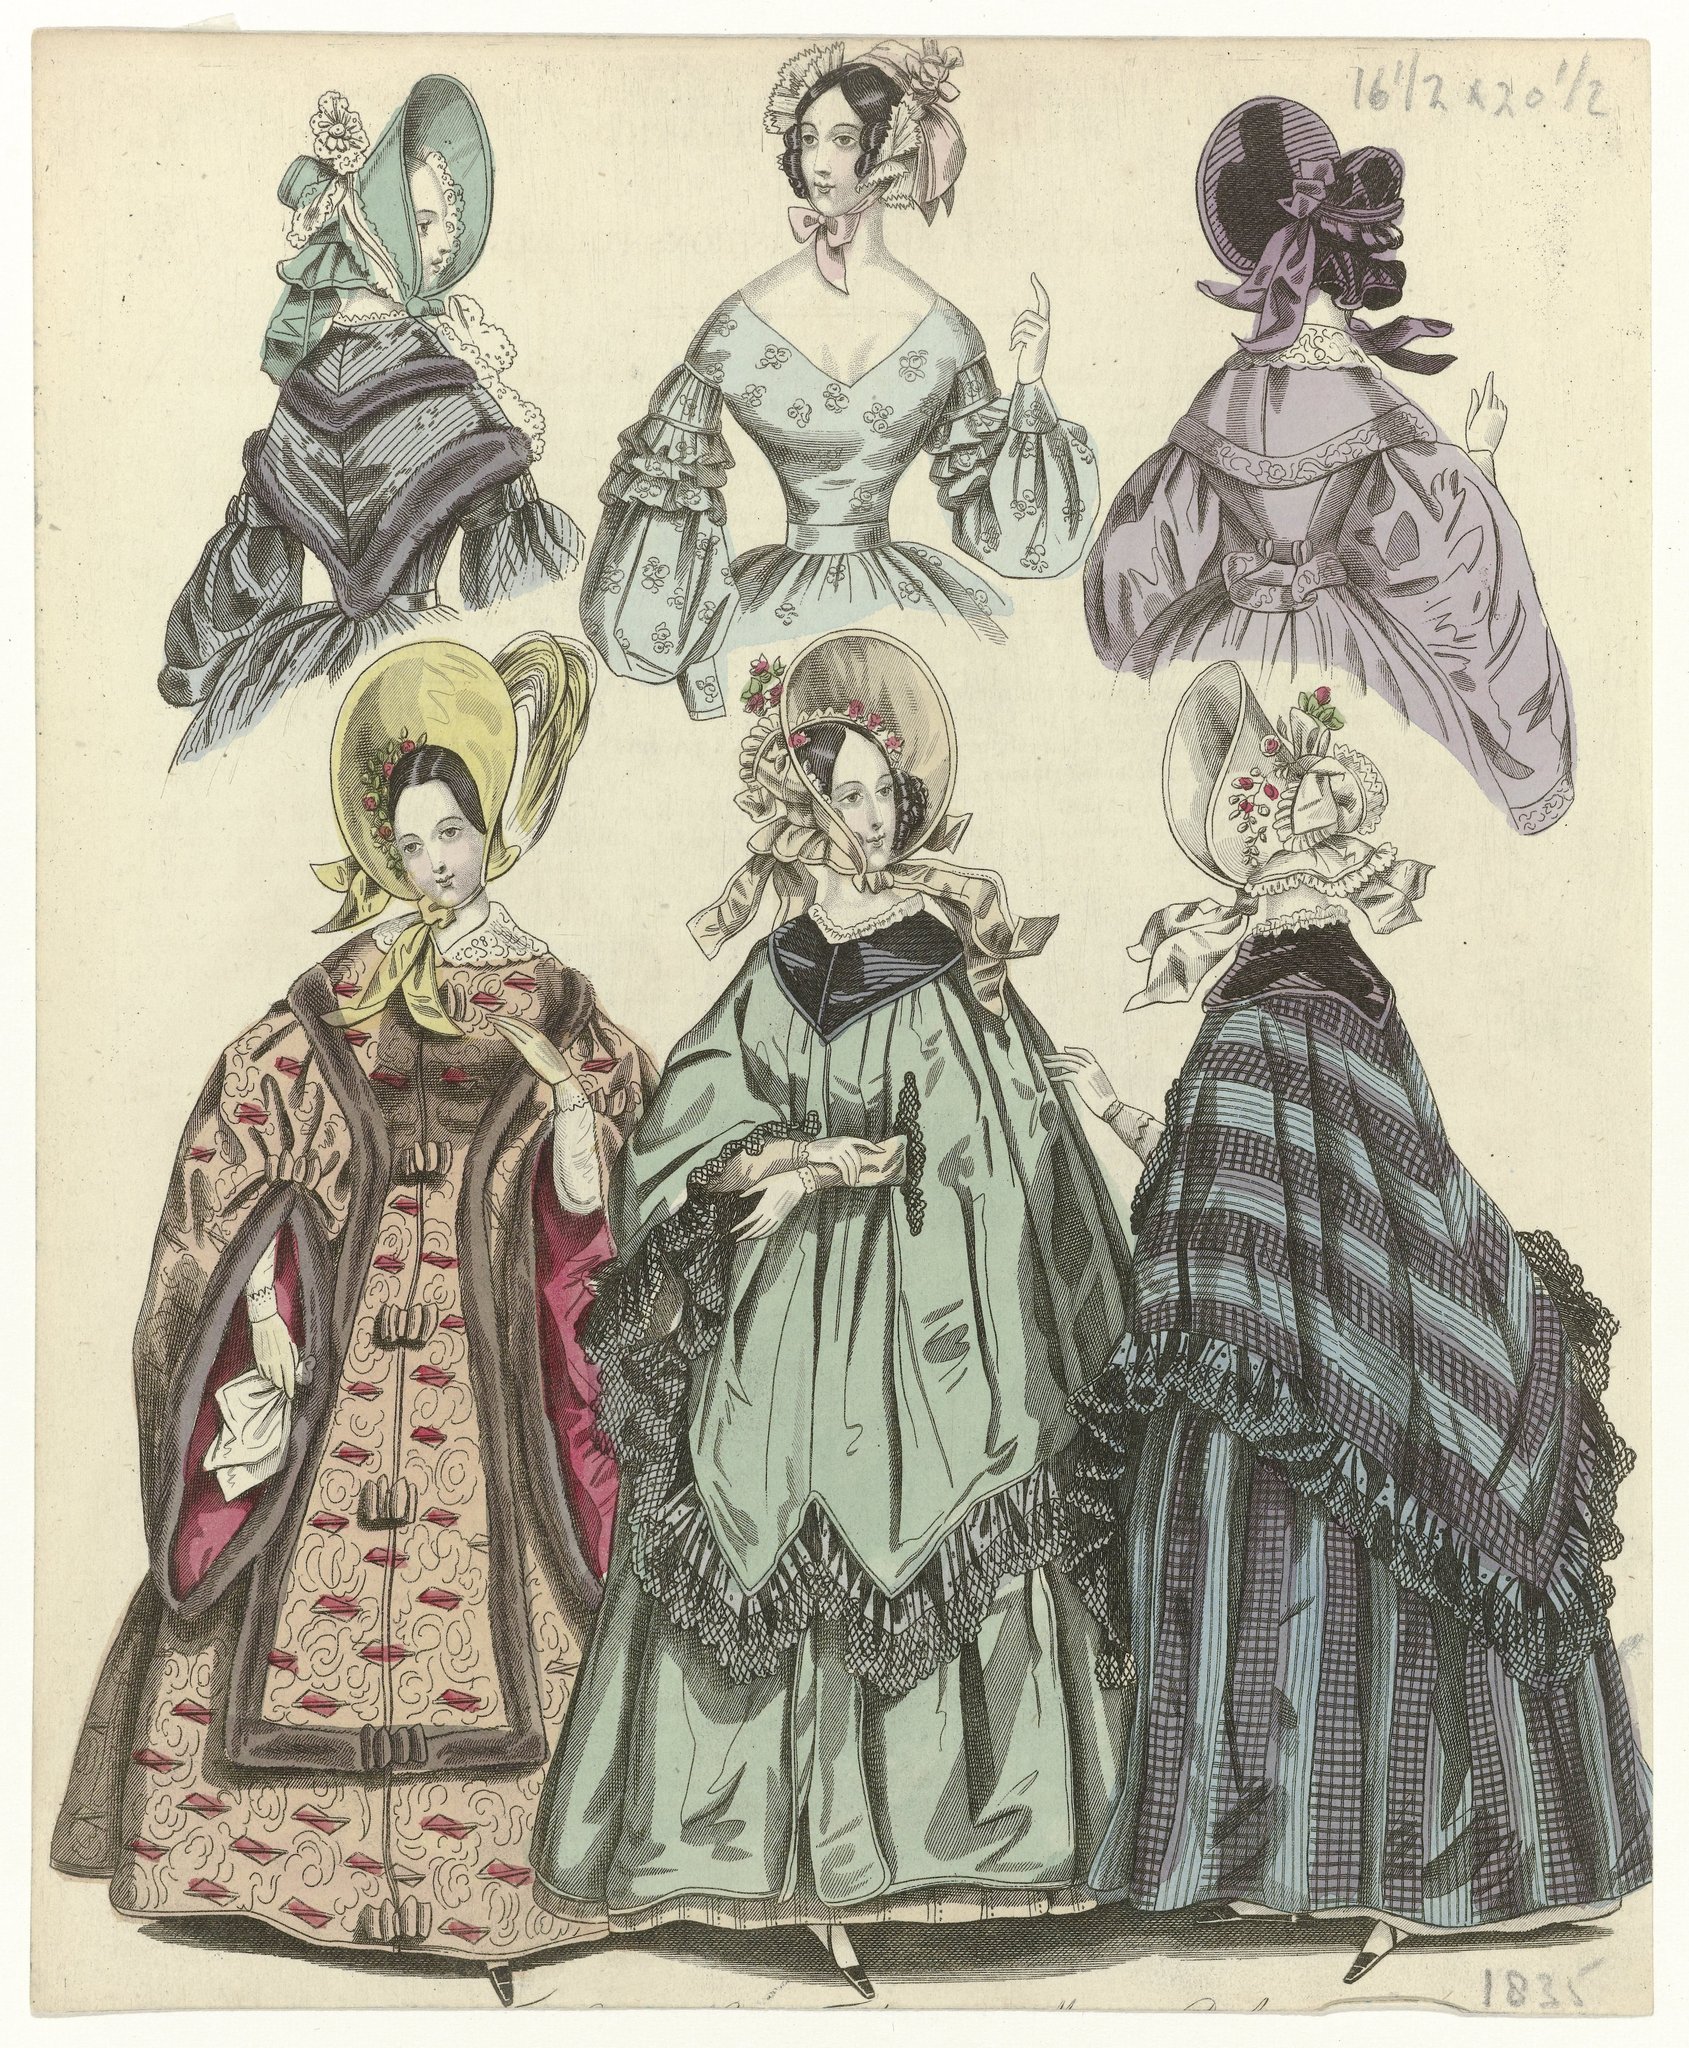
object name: fashion print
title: The World of Fashion, 1835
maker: Anonymous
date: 1835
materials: paper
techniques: etching, hand coloring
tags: handkerchief (+ women's clothes), coat (+ women's clothes), head-gear (+ women's clothes), fashion plates, shoes, sandals (+ women's clothes), gloves, mittens, etc. (+ women's clothes), dress, gown (+ women's clothes)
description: Mantel met wijd uitlopende mouwen, afgezet met bont. Mantel met armsgaten, afgezet met gerimpelde stroken stof. Accessoires: luifelhoeden, handschoenen, zakdoek, schoenen met vierkante neuzen. Daarboven drie vrouwen, ten halven lijve. Prent uit het modetijdschrift The World of Fashion (1824-1891).